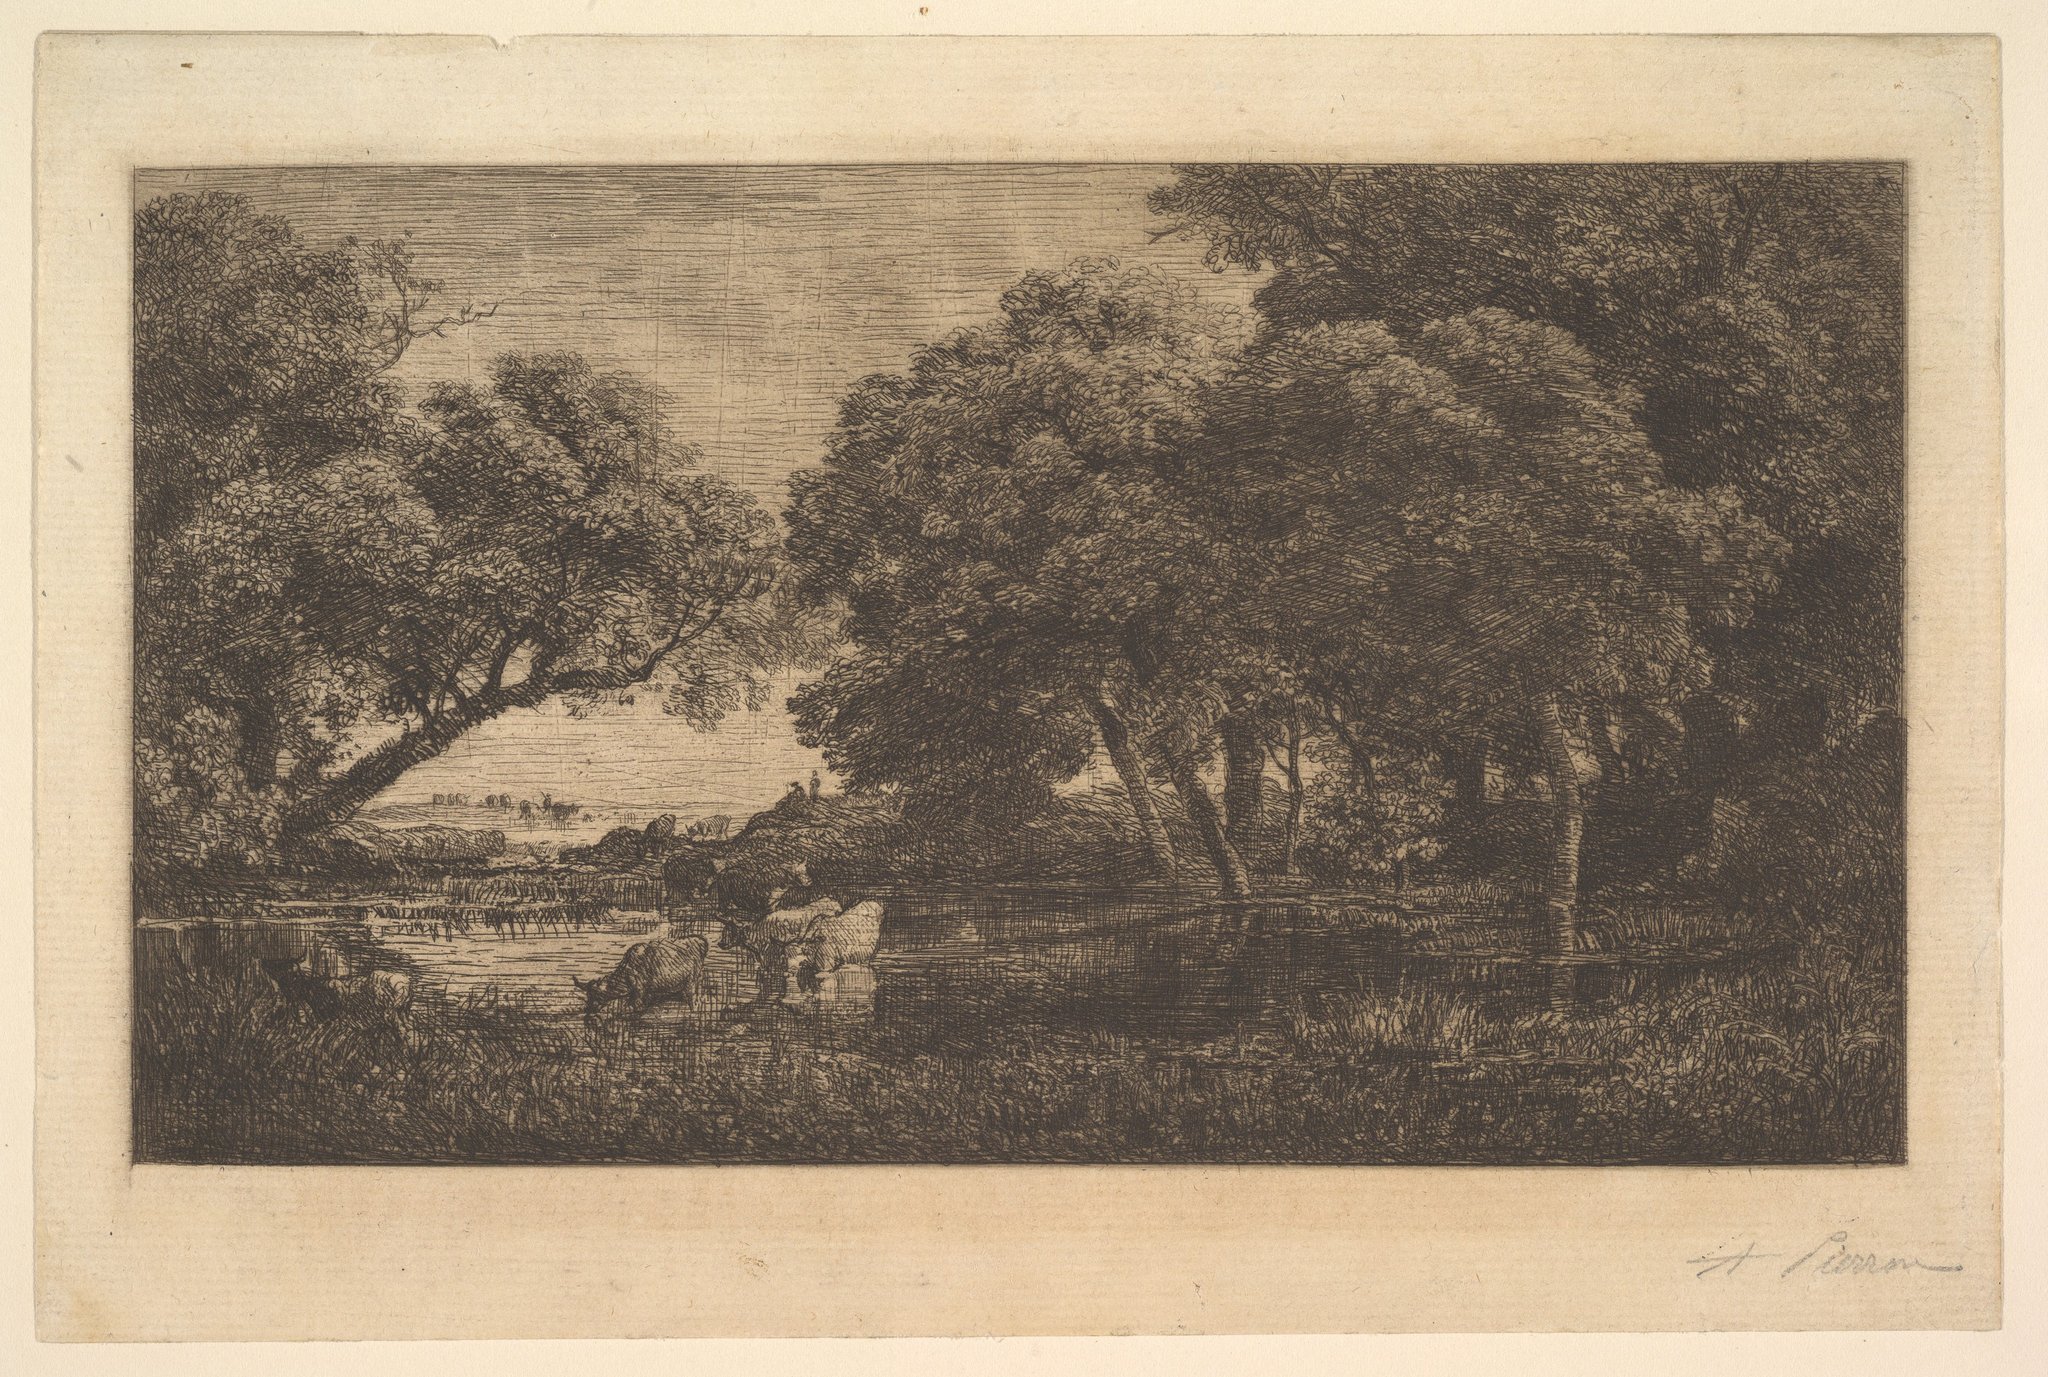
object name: print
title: Stags in Woods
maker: charles-françois daubigny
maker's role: artist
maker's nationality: french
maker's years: 1817-1878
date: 1850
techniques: etching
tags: cows,forests,landscapes